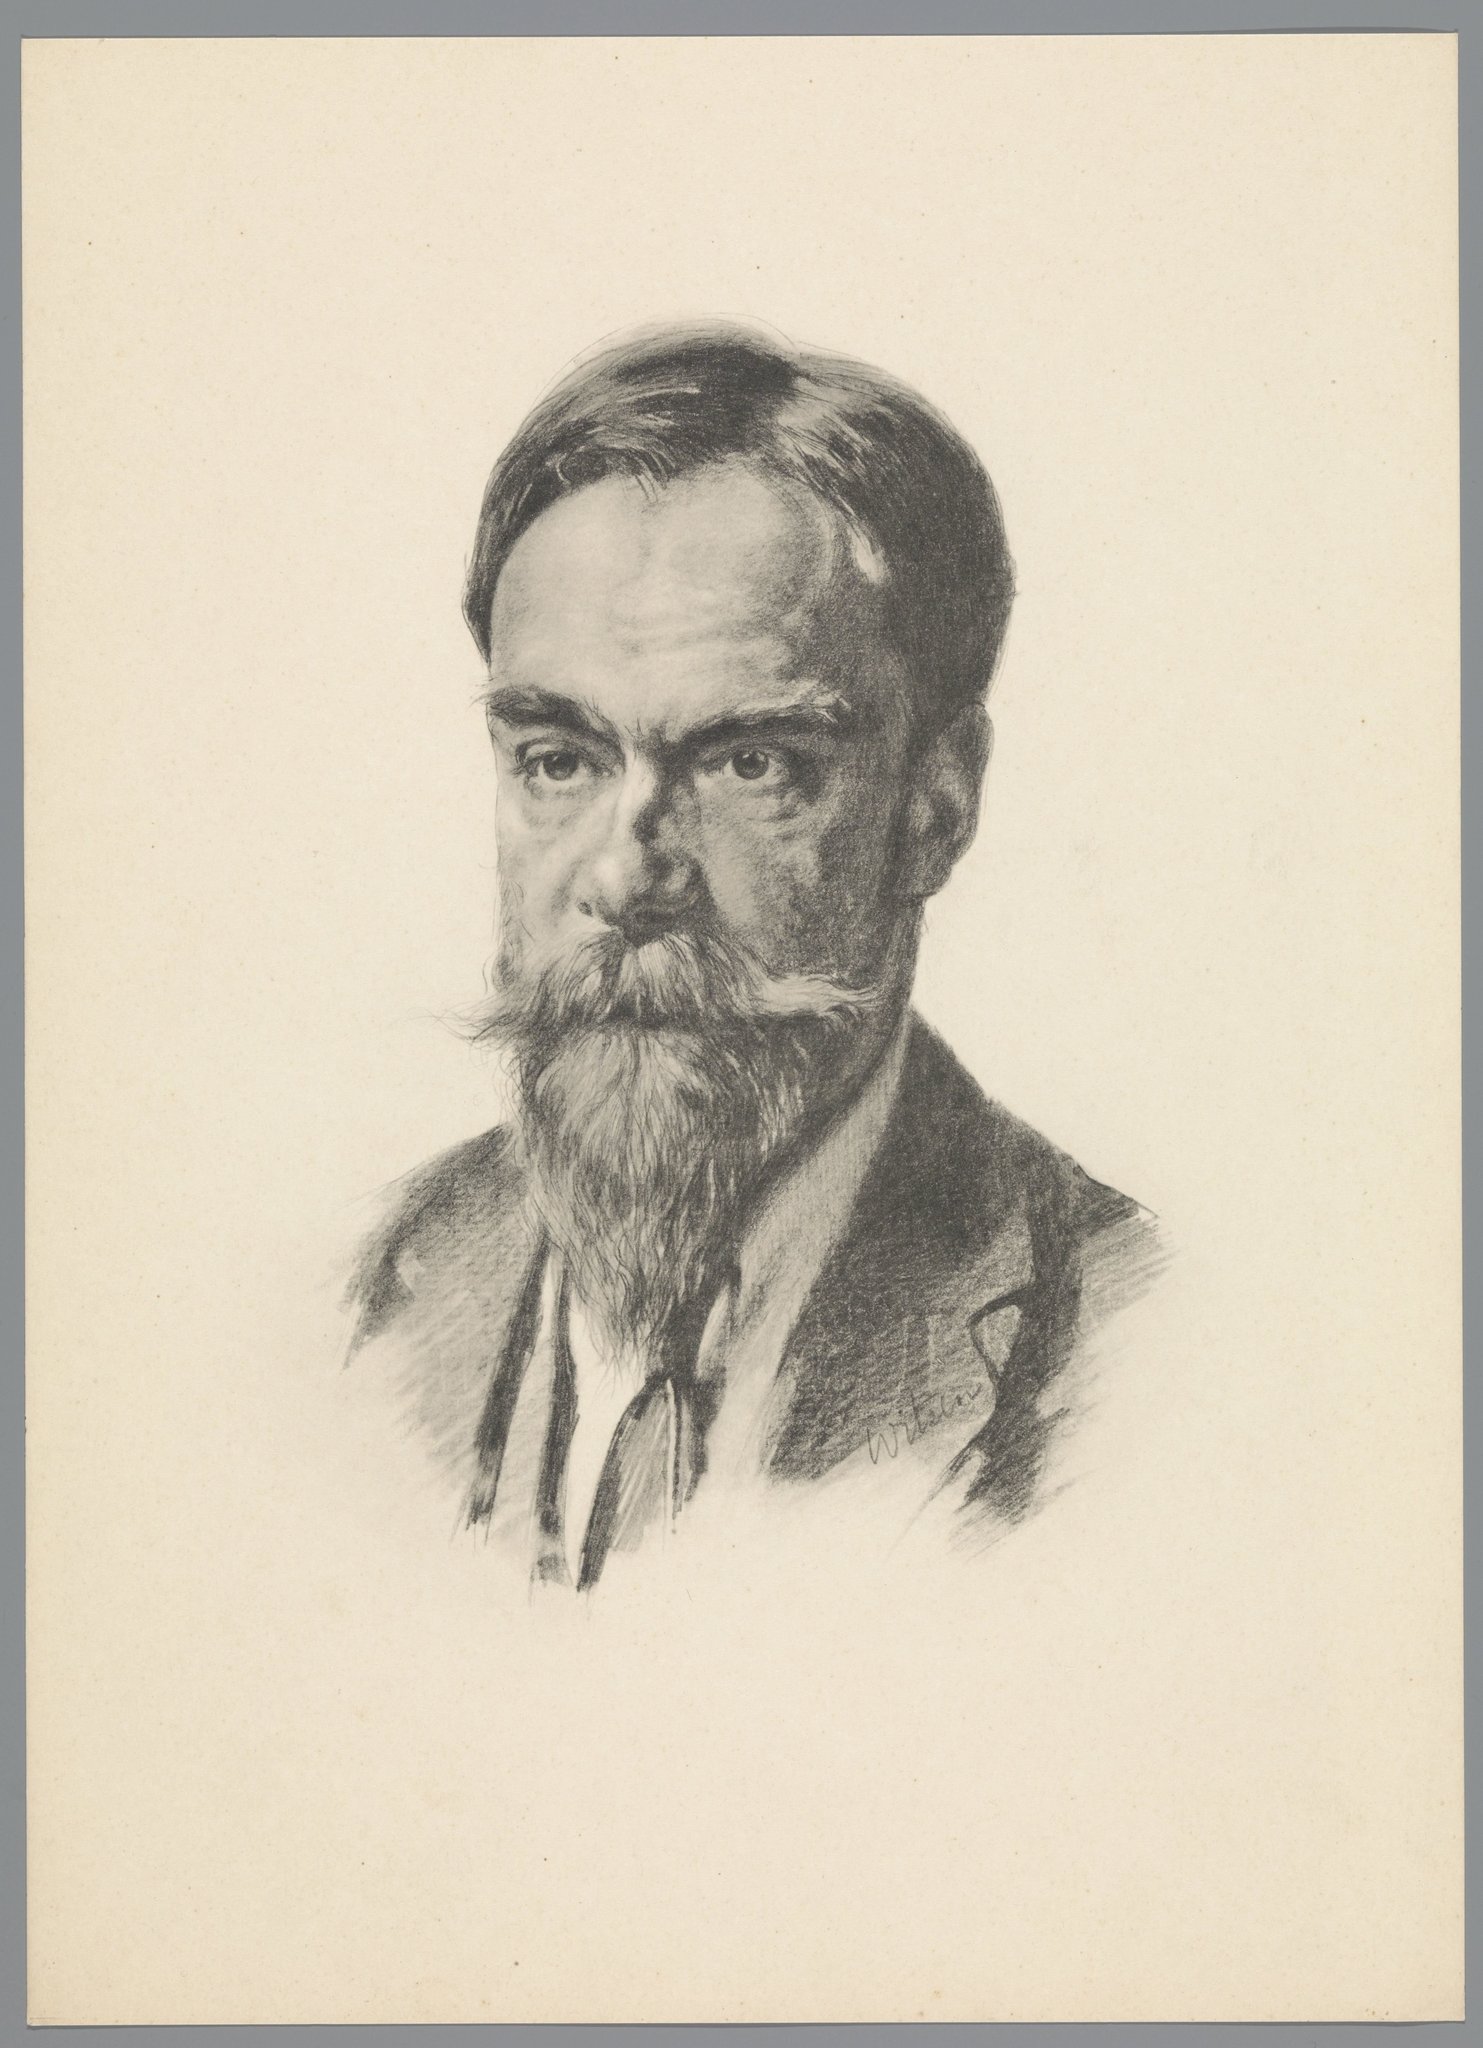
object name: print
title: Reproductie naar krijttekening met portret van Frans Coenen Jr.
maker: Anonymous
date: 1860-1915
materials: paper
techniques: photograph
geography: netherlands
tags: frans coenen (1866-1936)